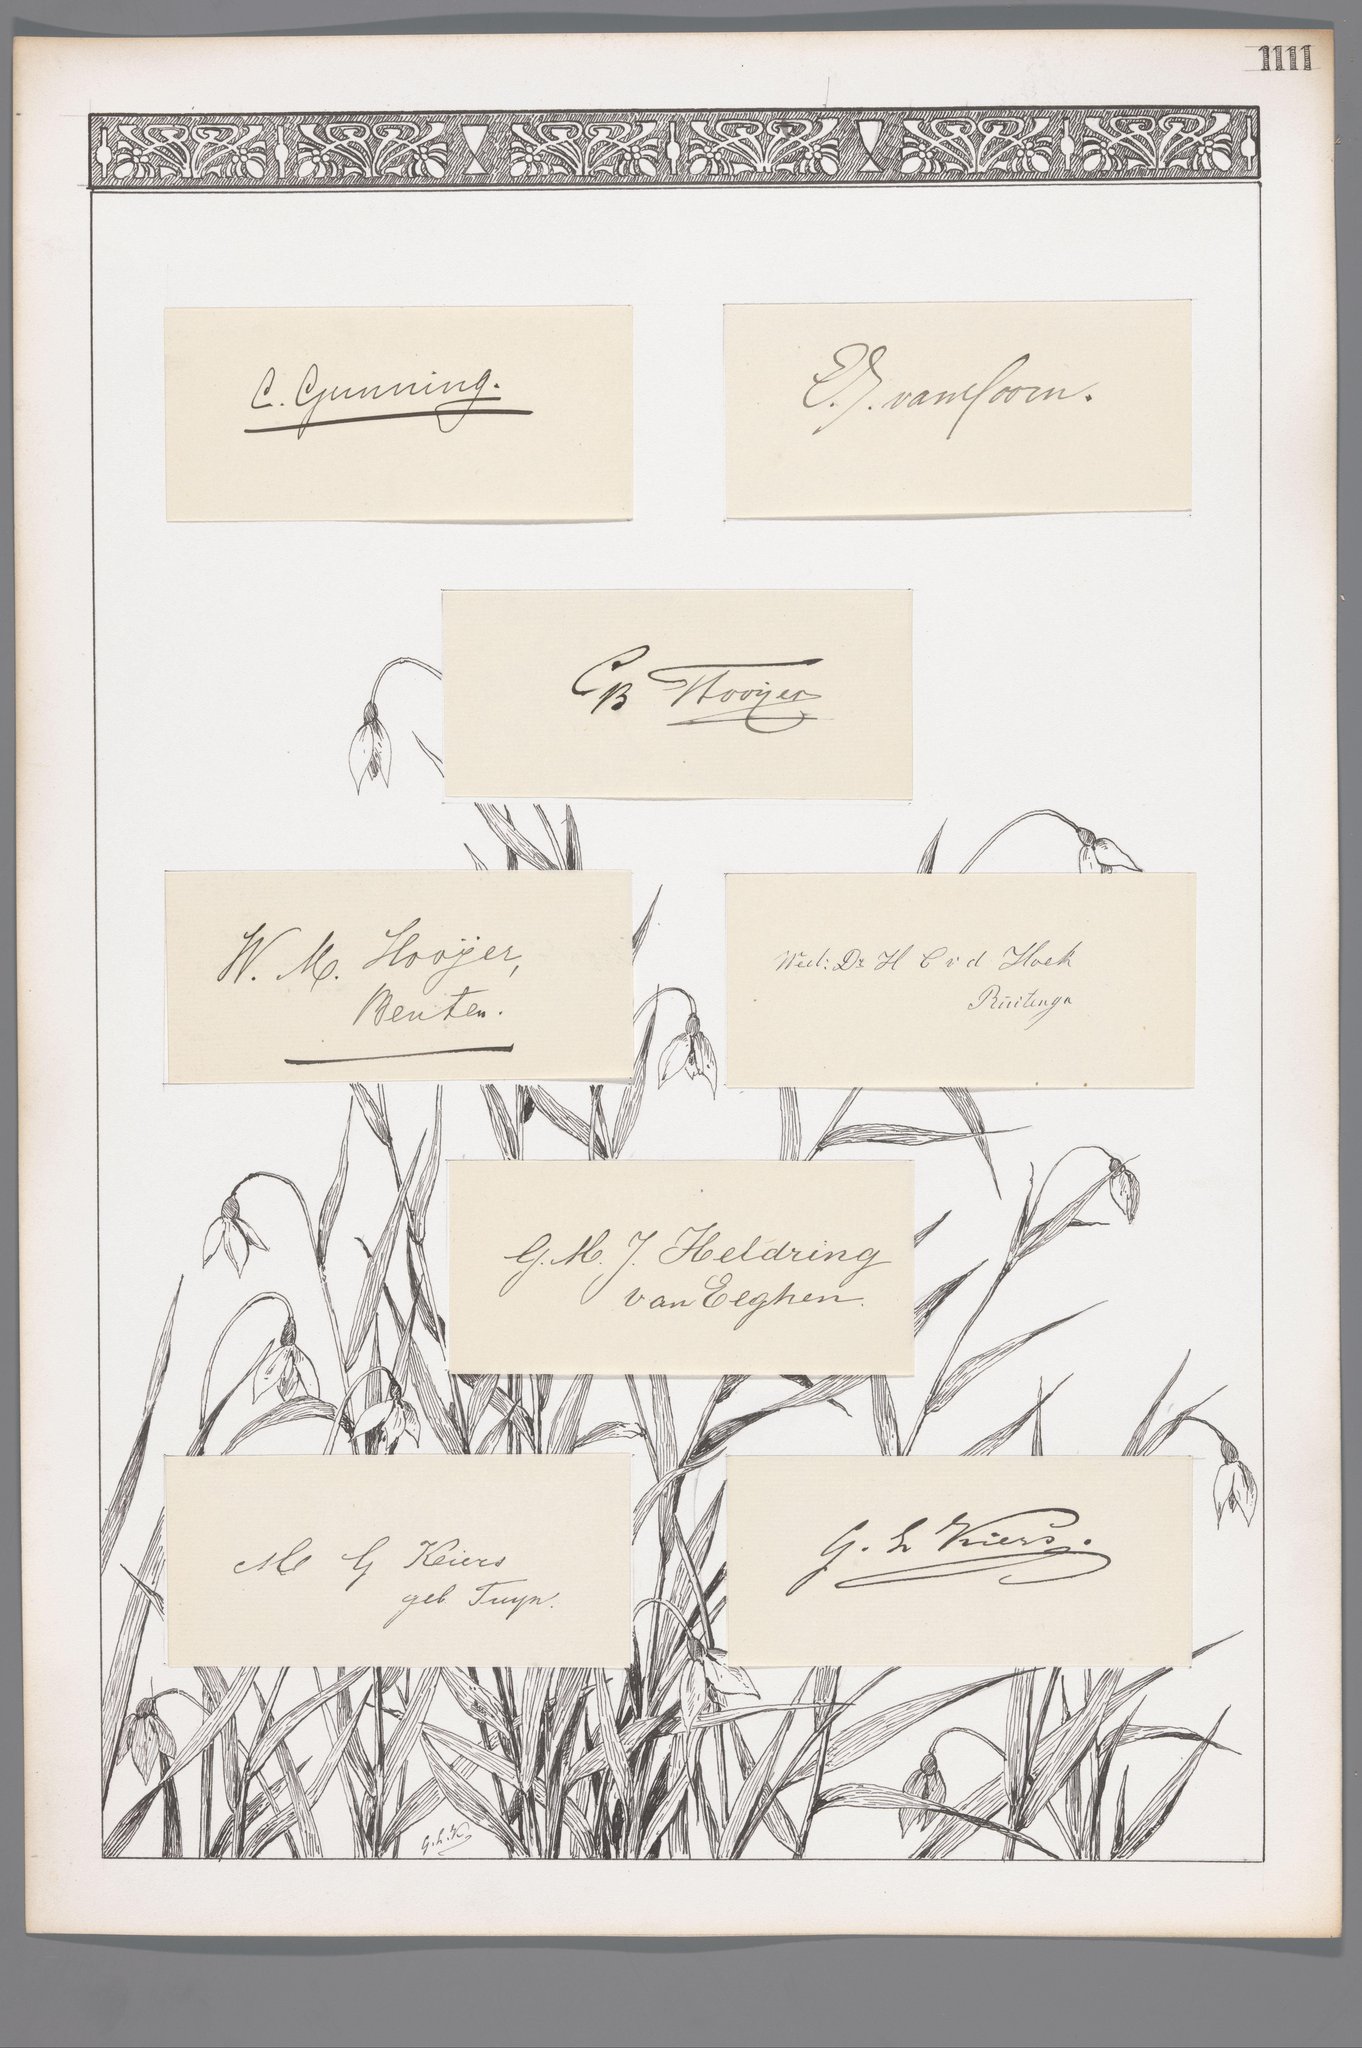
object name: drawing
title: Acht handtekeningen geplakt op een blad met sneeuwklokjes en decoratieve rand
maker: george lourens kiers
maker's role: draughtsman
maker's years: 1838-1916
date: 1904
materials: ink, paper, pencil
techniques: pen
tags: painter, harlingen, amsterdam, draughtsman, george lourens kiers, flowers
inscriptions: number: ‘IIII’